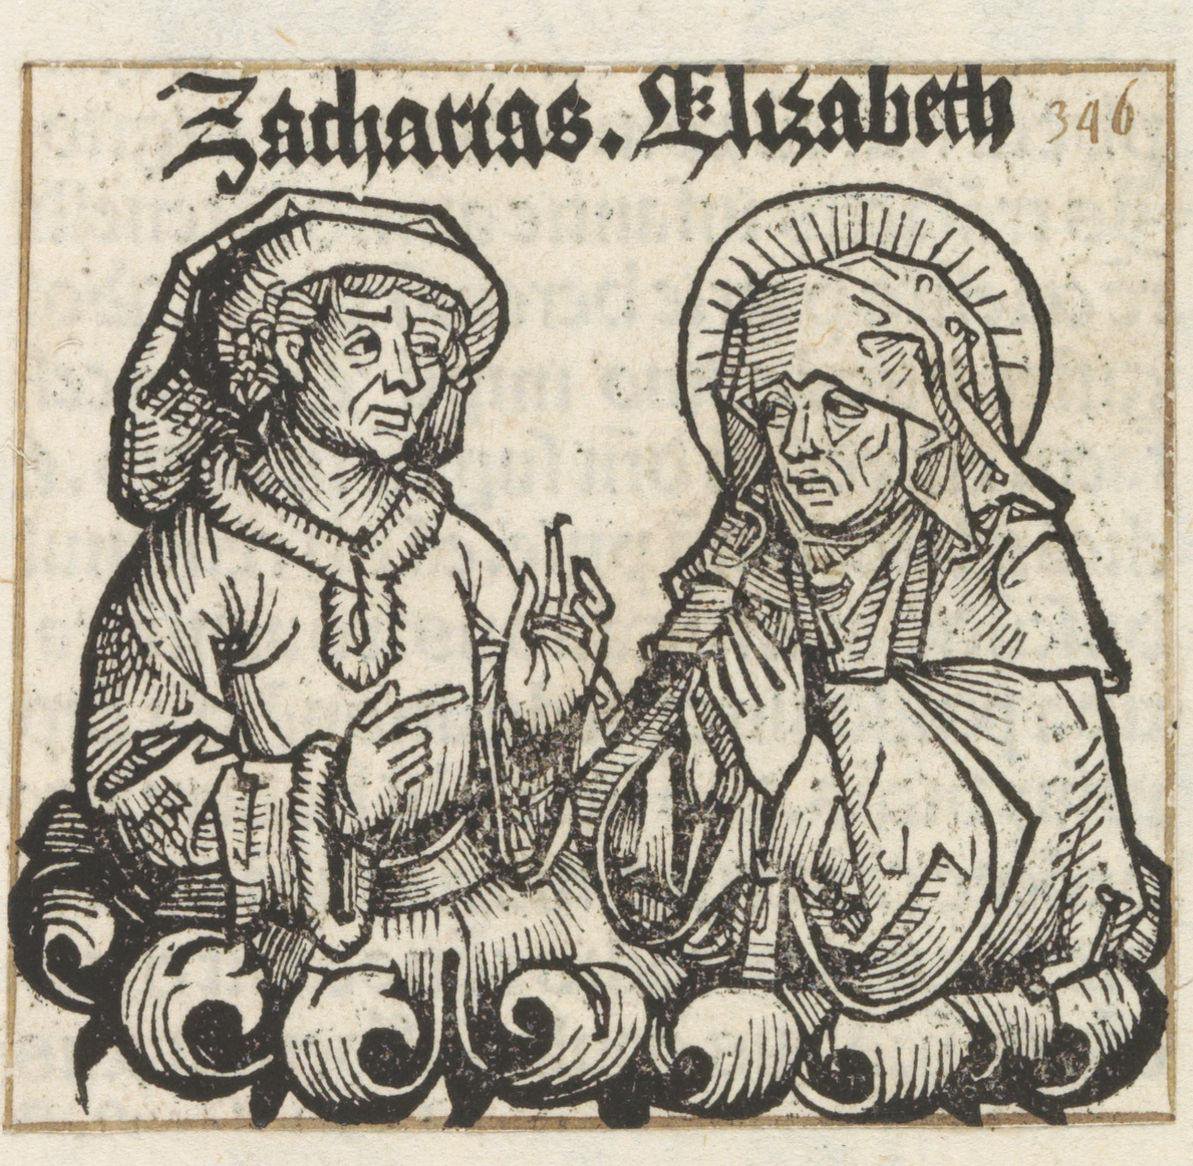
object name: book illustration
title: Zacharias en Elisabet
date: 1493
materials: paper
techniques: letterpress printing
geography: nuremberg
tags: persons from the old testament (not in biblical context, nor occurring in legendary/historical extensions included in division 71)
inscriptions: inscription: ‘346’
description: De houtsnede wordt gebruikt als boekillustratie in de Liber Chronicarum (of Neurenbergkroniek) van Hartmann Schedel, verschenen in het Latijn en Duits in 1493. Zie de Latijnse uitgave, folio 94r.